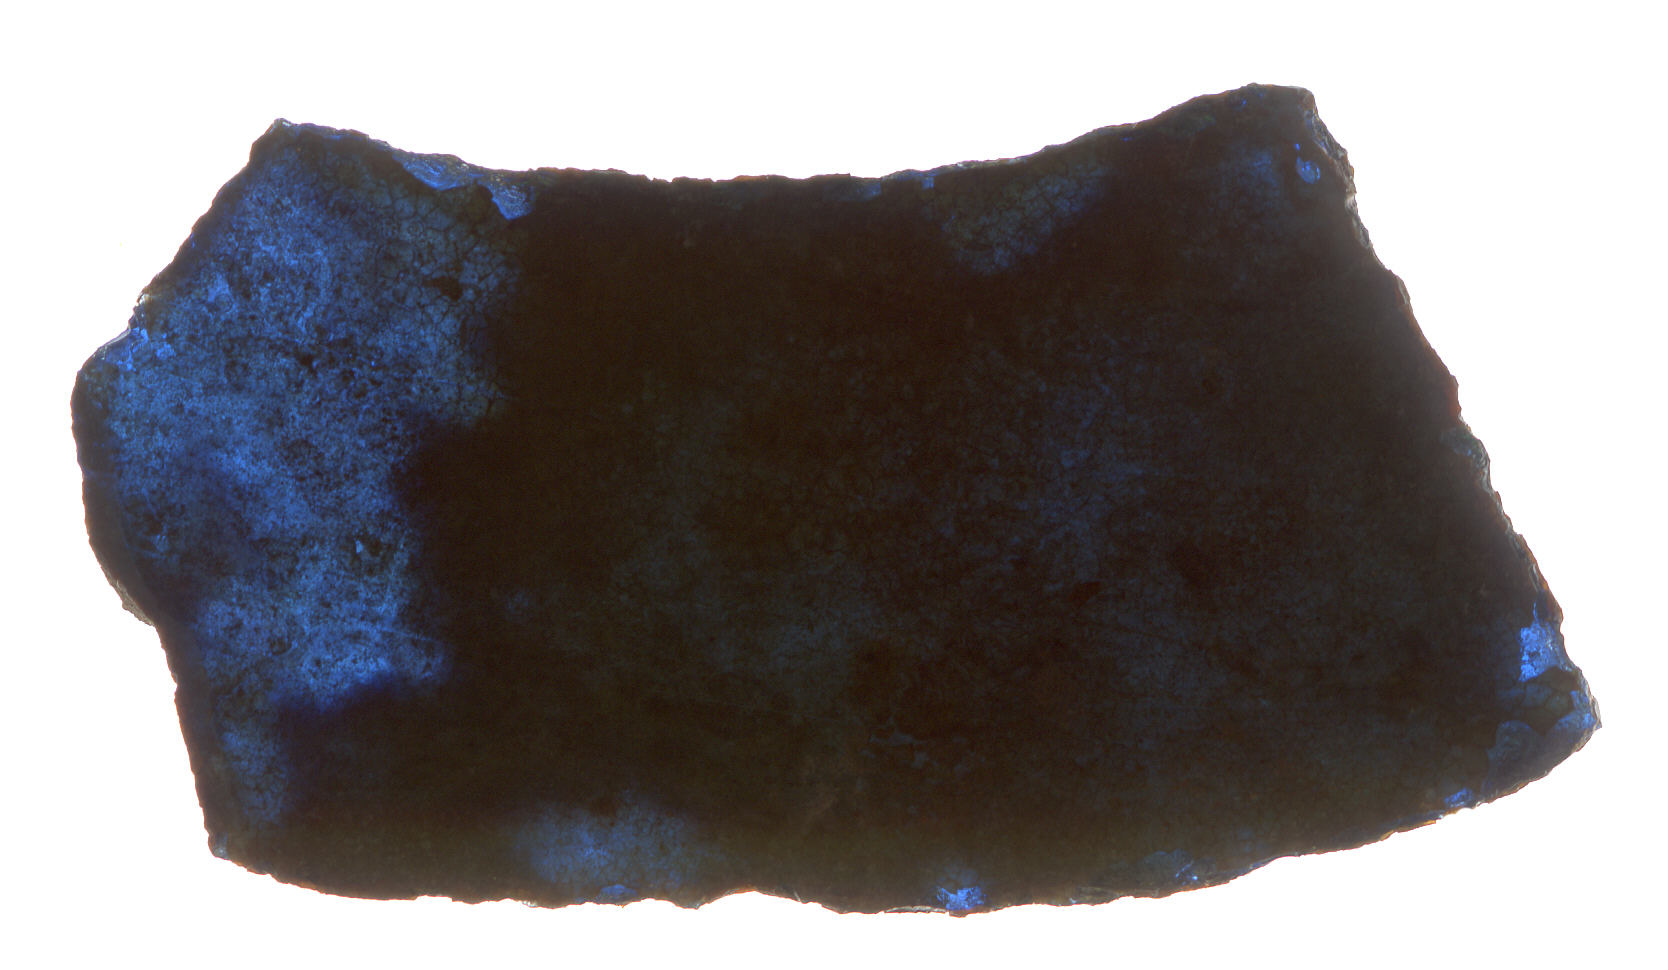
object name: fragment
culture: crusader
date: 1201-1300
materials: glass